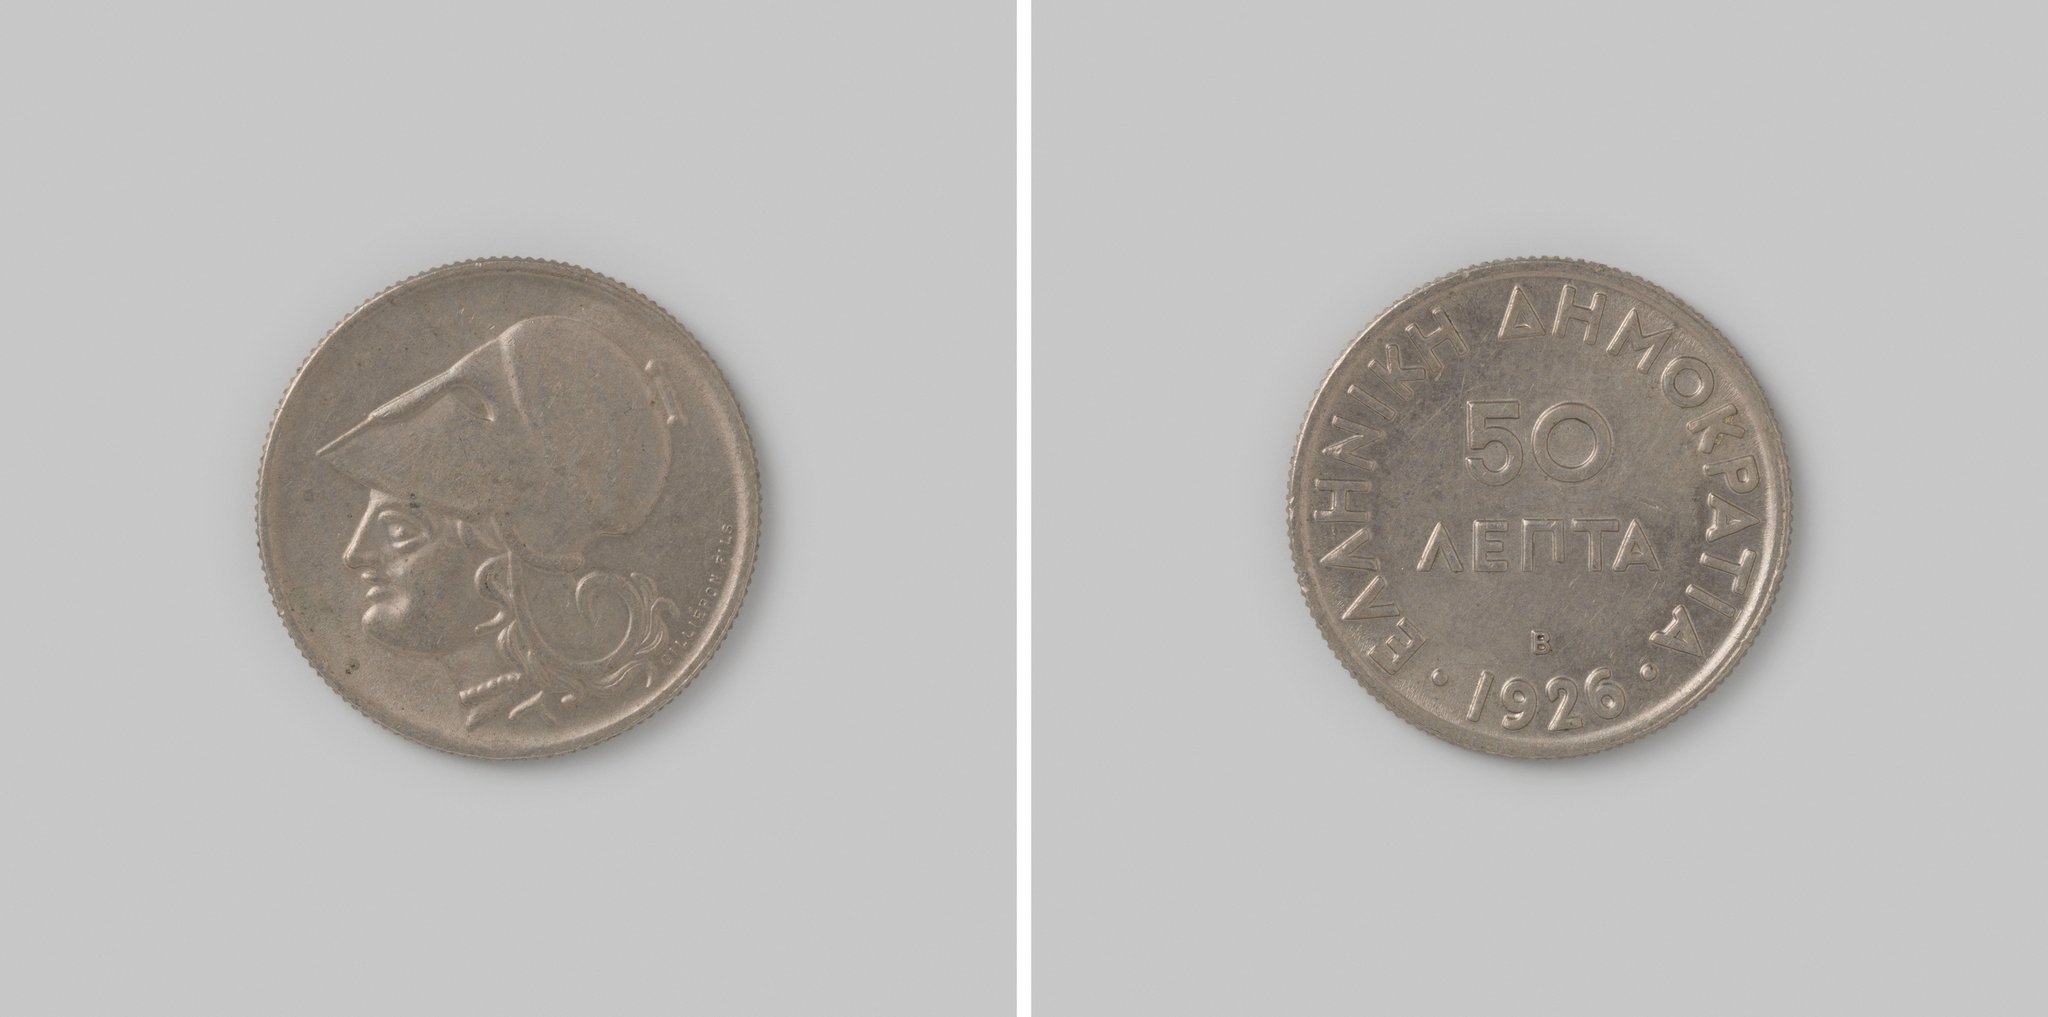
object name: coin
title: Griekenland, 50 lepta, 1926 B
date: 1926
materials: nickel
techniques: striking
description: Koper-nikkelen munt. Voorzijde: gehelmde Athene naar links. Keerzijde: waarde-aanduiding in twee regels, waaronder letter B. Jaartal onderaan. Kartelrand.